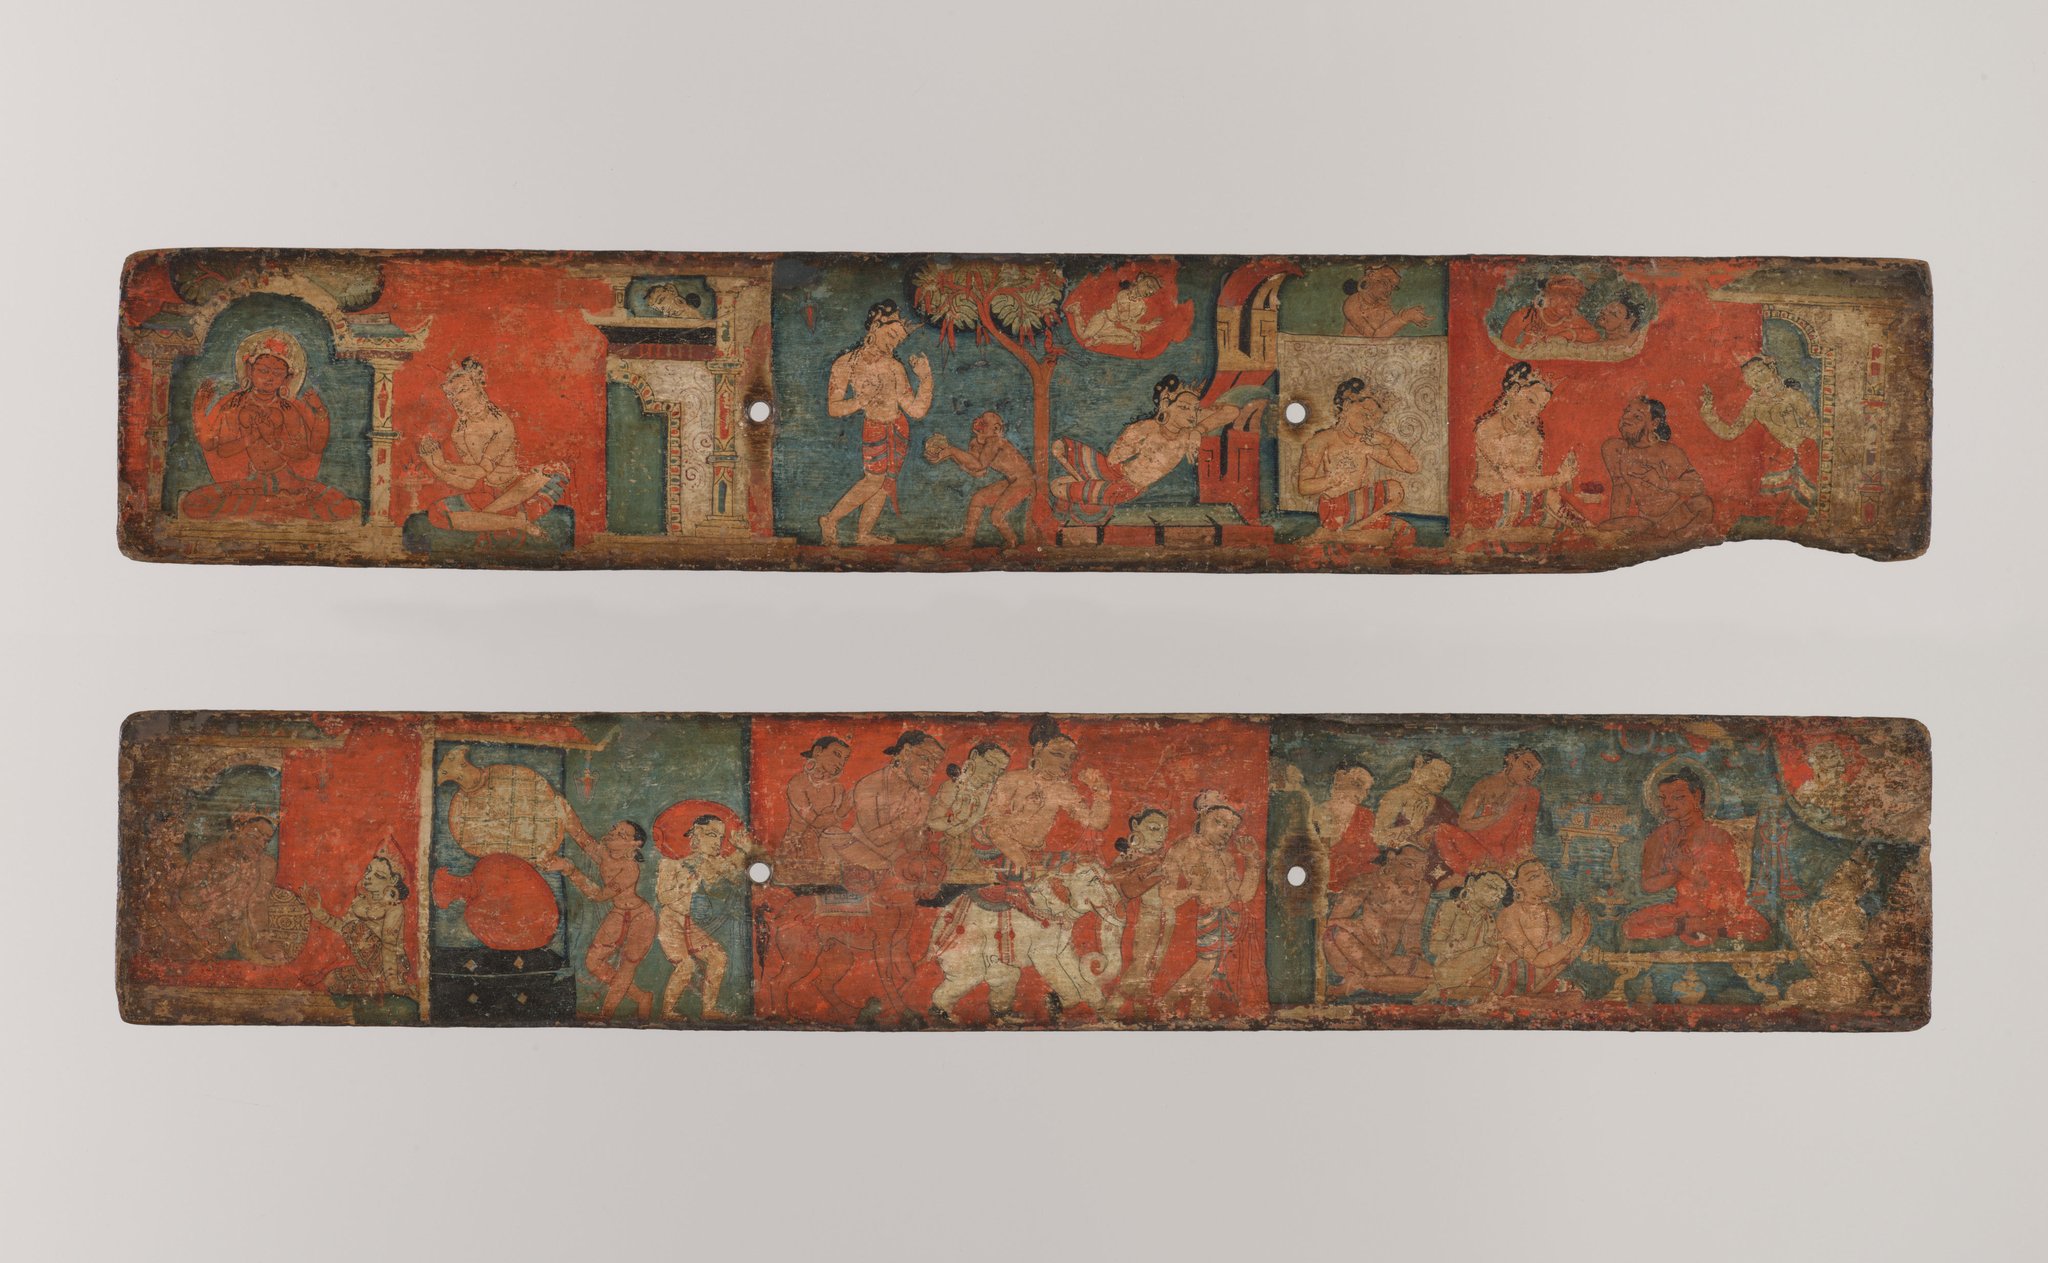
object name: manuscript cover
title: Pair of Manuscript Covers Illustrating Sadaprarudita’s Self-Sacrifice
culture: nepali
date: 1101-1200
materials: wood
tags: men,women,elephants,buddhism,buddha